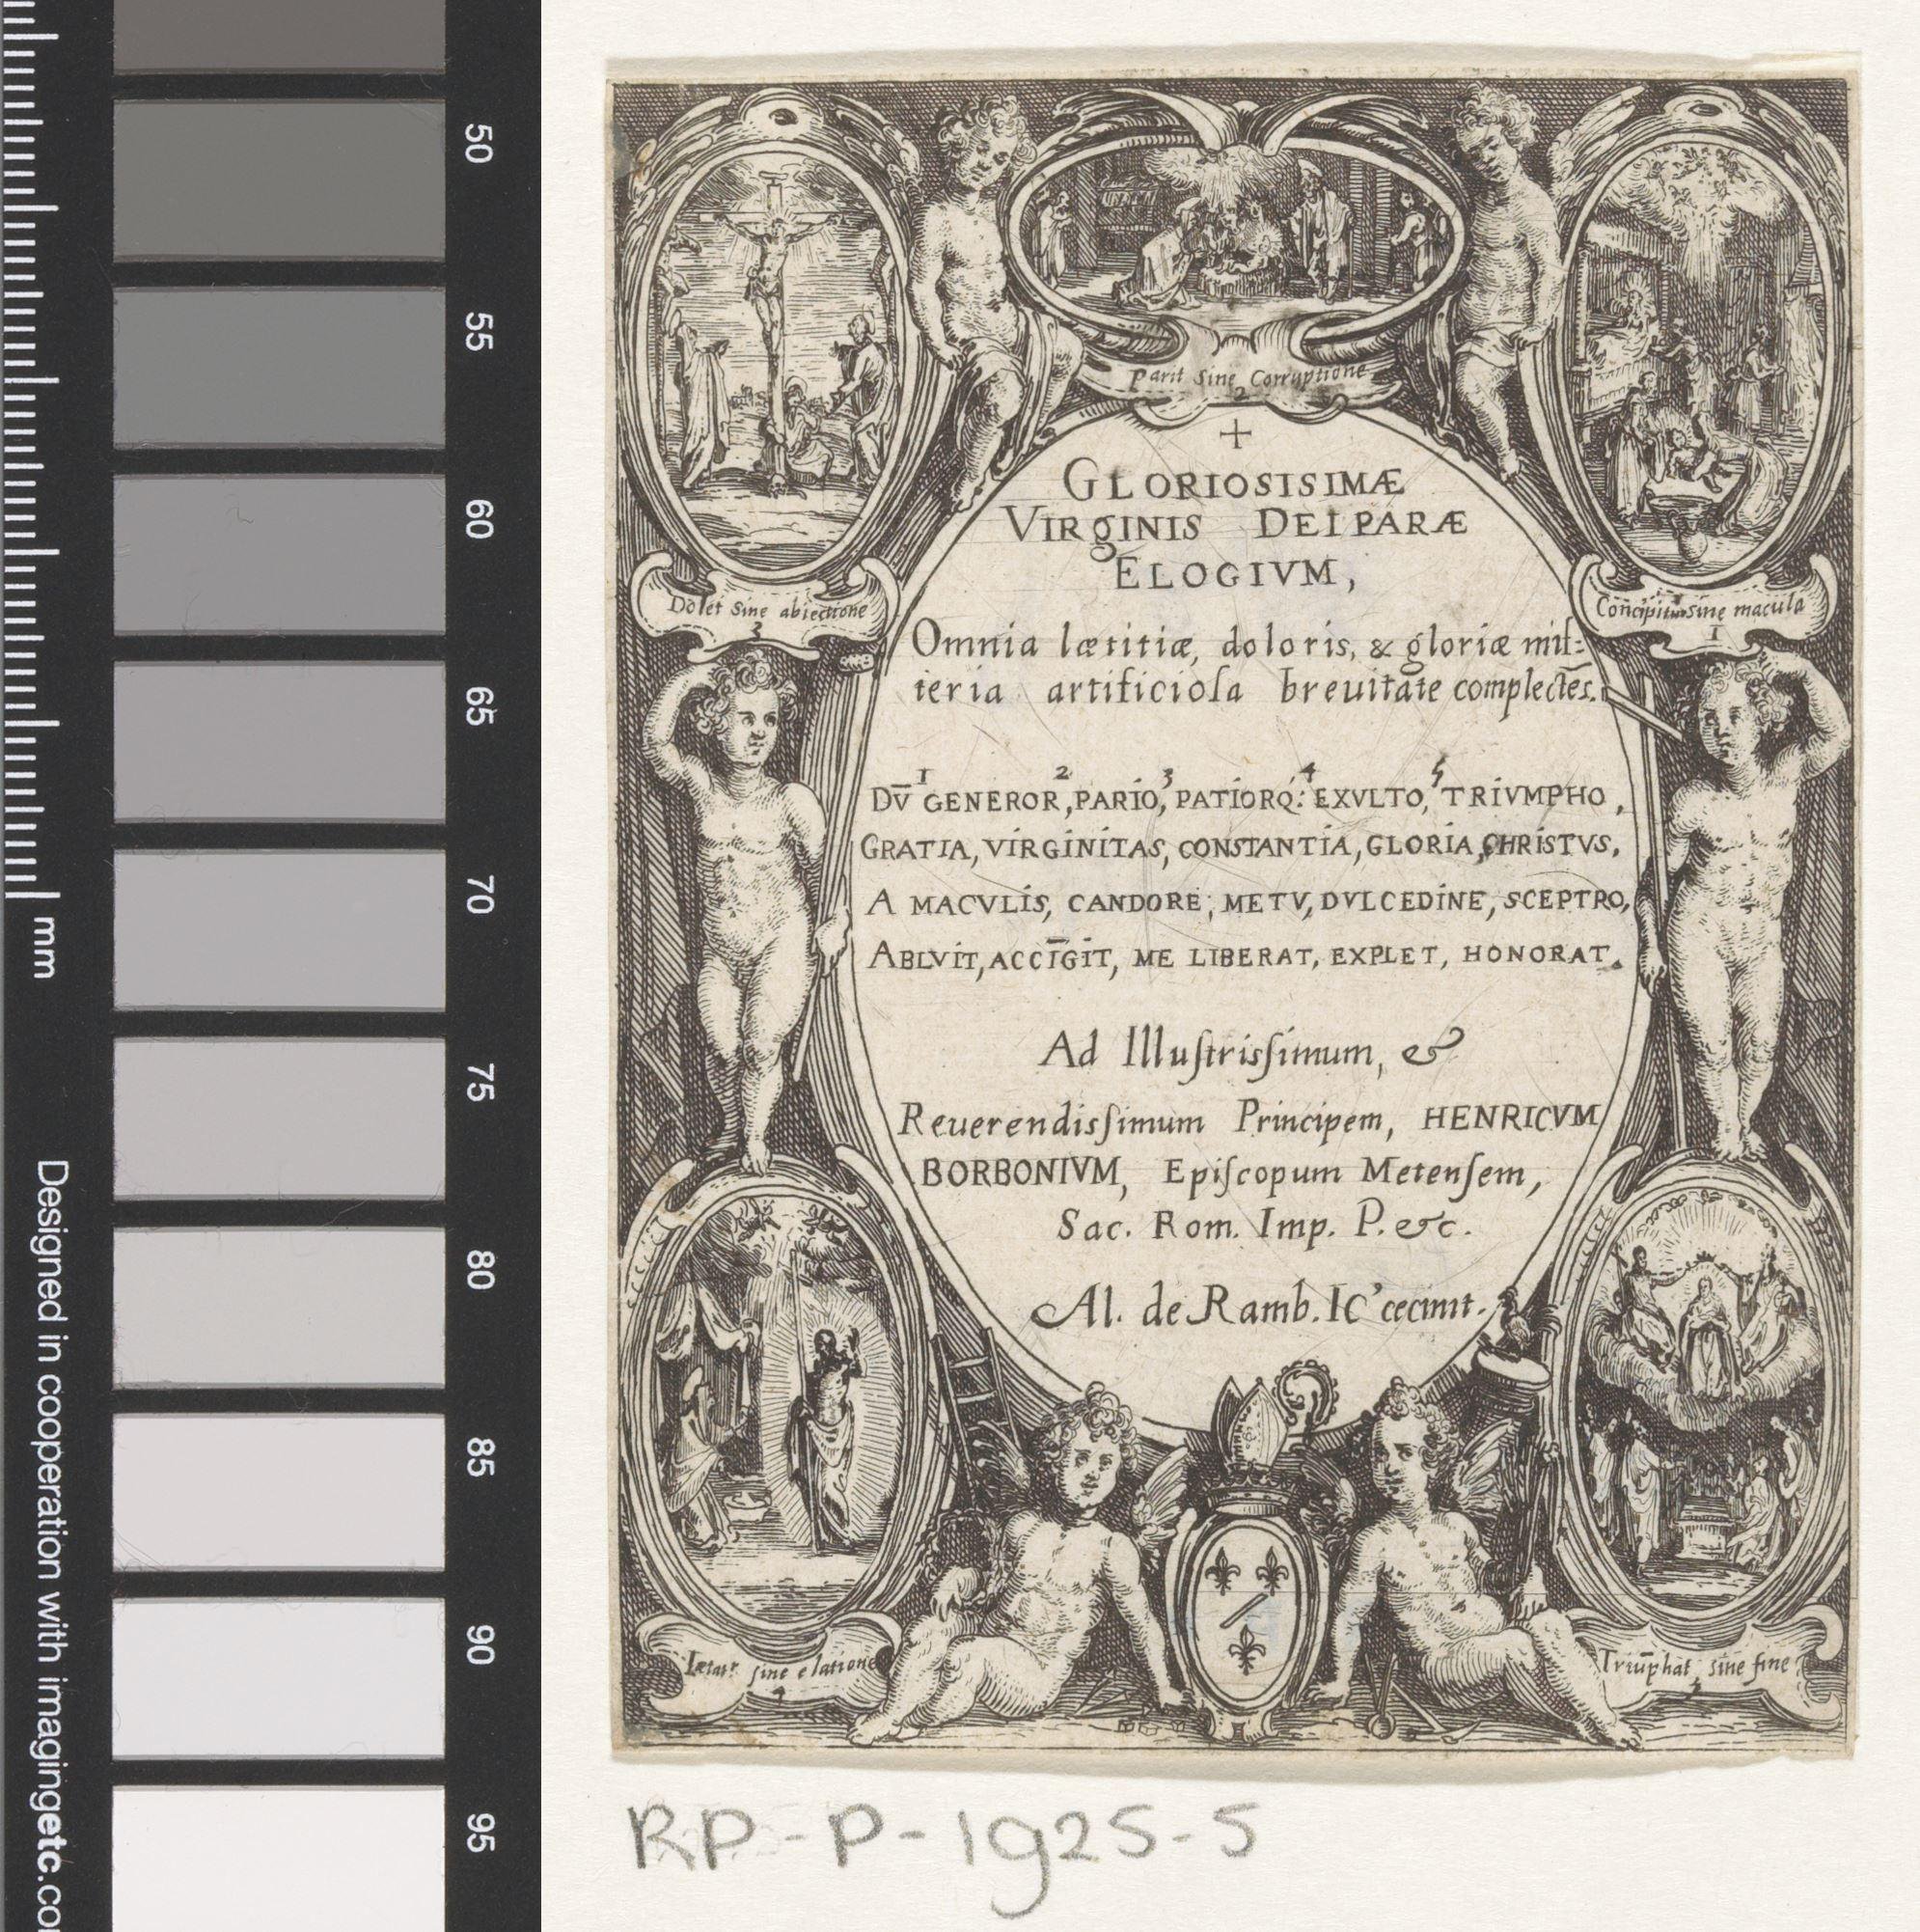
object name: print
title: Gloriosisimae Virginis Dei Parae Elogium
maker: jacques callot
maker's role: draughtsman, print maker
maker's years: 1592-1635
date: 1622-1629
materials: paper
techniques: etching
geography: nancy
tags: adoration of the christ-child by mary and joseph, crucified christ with mary, john, and mary magdalene, birth of mary, christ, perhaps dressed as a pilgrim, appearing to his mother, who is usually shown praying, assumption of mary combined with her coronation, series of scenes from the life of mary, ornament ~ cartouche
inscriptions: collector's mark: Lugt 2228, collector's mark: Lugt 2233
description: Ovale cartouche met Latijnse titel, waaromheen zes putti, vijf medaillons met scènes uit het leven van Maria en een wapenschild. De verhalende scènes betreffen van rechts boven tot rechts onder (tegen de klok in): Geboorte van Maria, Geboorte van Christus, Kruisiging, Christus verschijnt na zijn dood aan Maria, Hemelvaart en kroning van Maria.